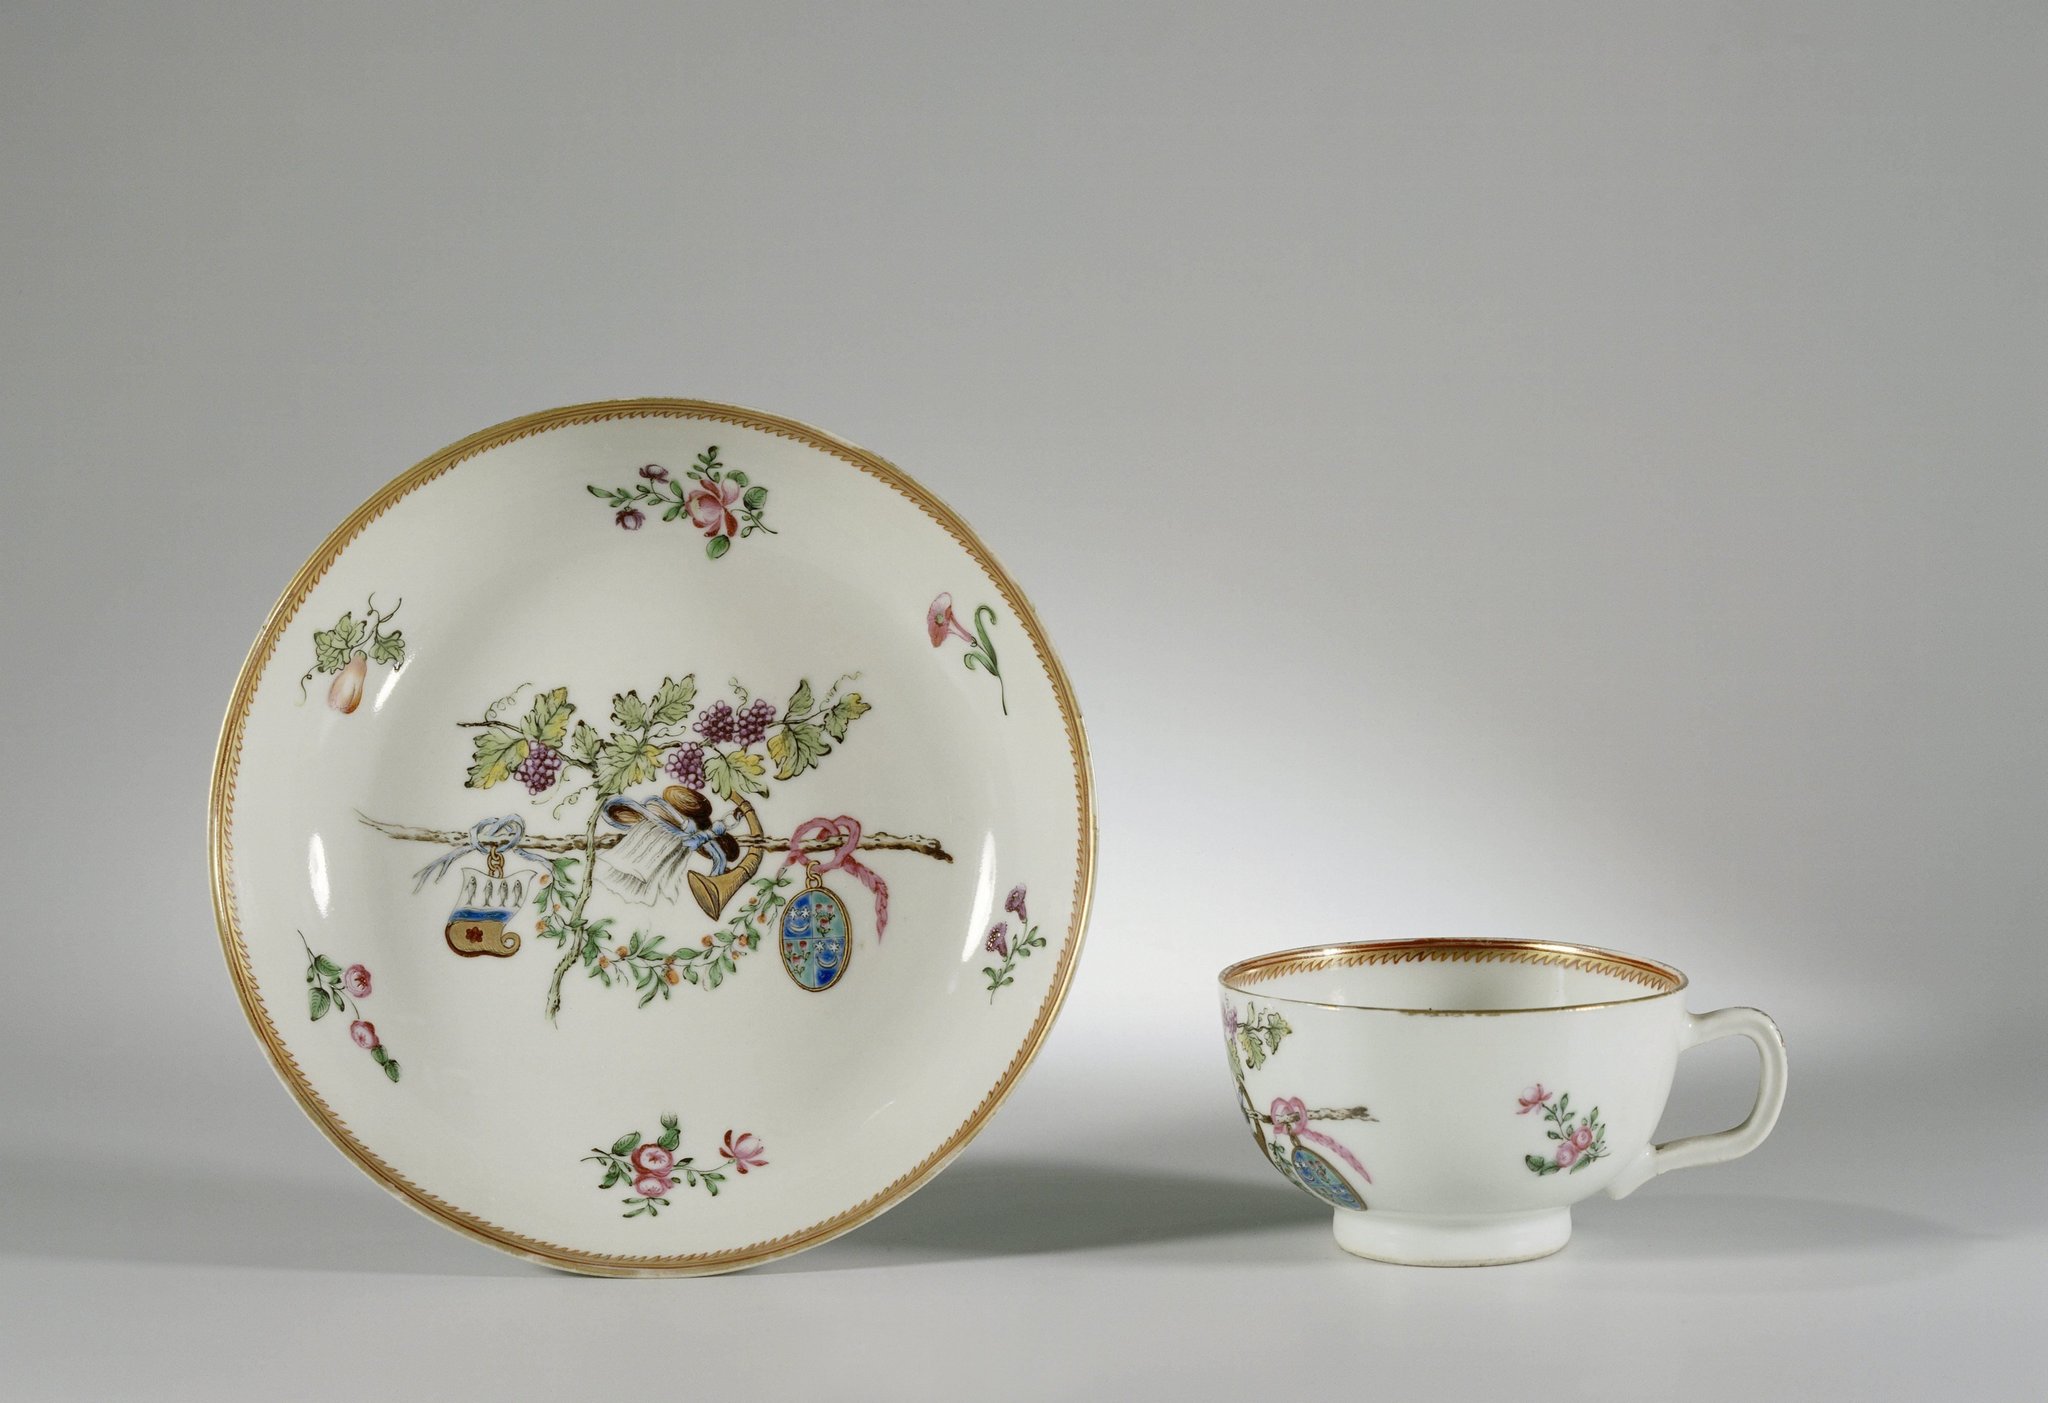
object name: kop en schotel, kop en schotel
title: Cup with handle and saucer with the arms of the Visvliet and Sluymer families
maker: Anonymous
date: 1777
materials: glaze, gold, paint, porcelain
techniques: firing, gilding, turning, vitrification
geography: china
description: In het centrum hangen twee wapens, verbonden door een guirlande, aan bloem- en vruchtentakken. Het wapen links is van de familie Van Visvliet en is opgedeeld in twee velden met vissen en een roos. Het wapen rechts is van de familie Sluijmer en is opgedeeld in vier velden, met hemellichamen, en rode bloemen. Aan de takken zijn, behalve de wapens, een dameshoed, een blad papier en een hoorn bevestigd. De kop en schotel zijn verder versierd met strooibloemen en een rand in goud.